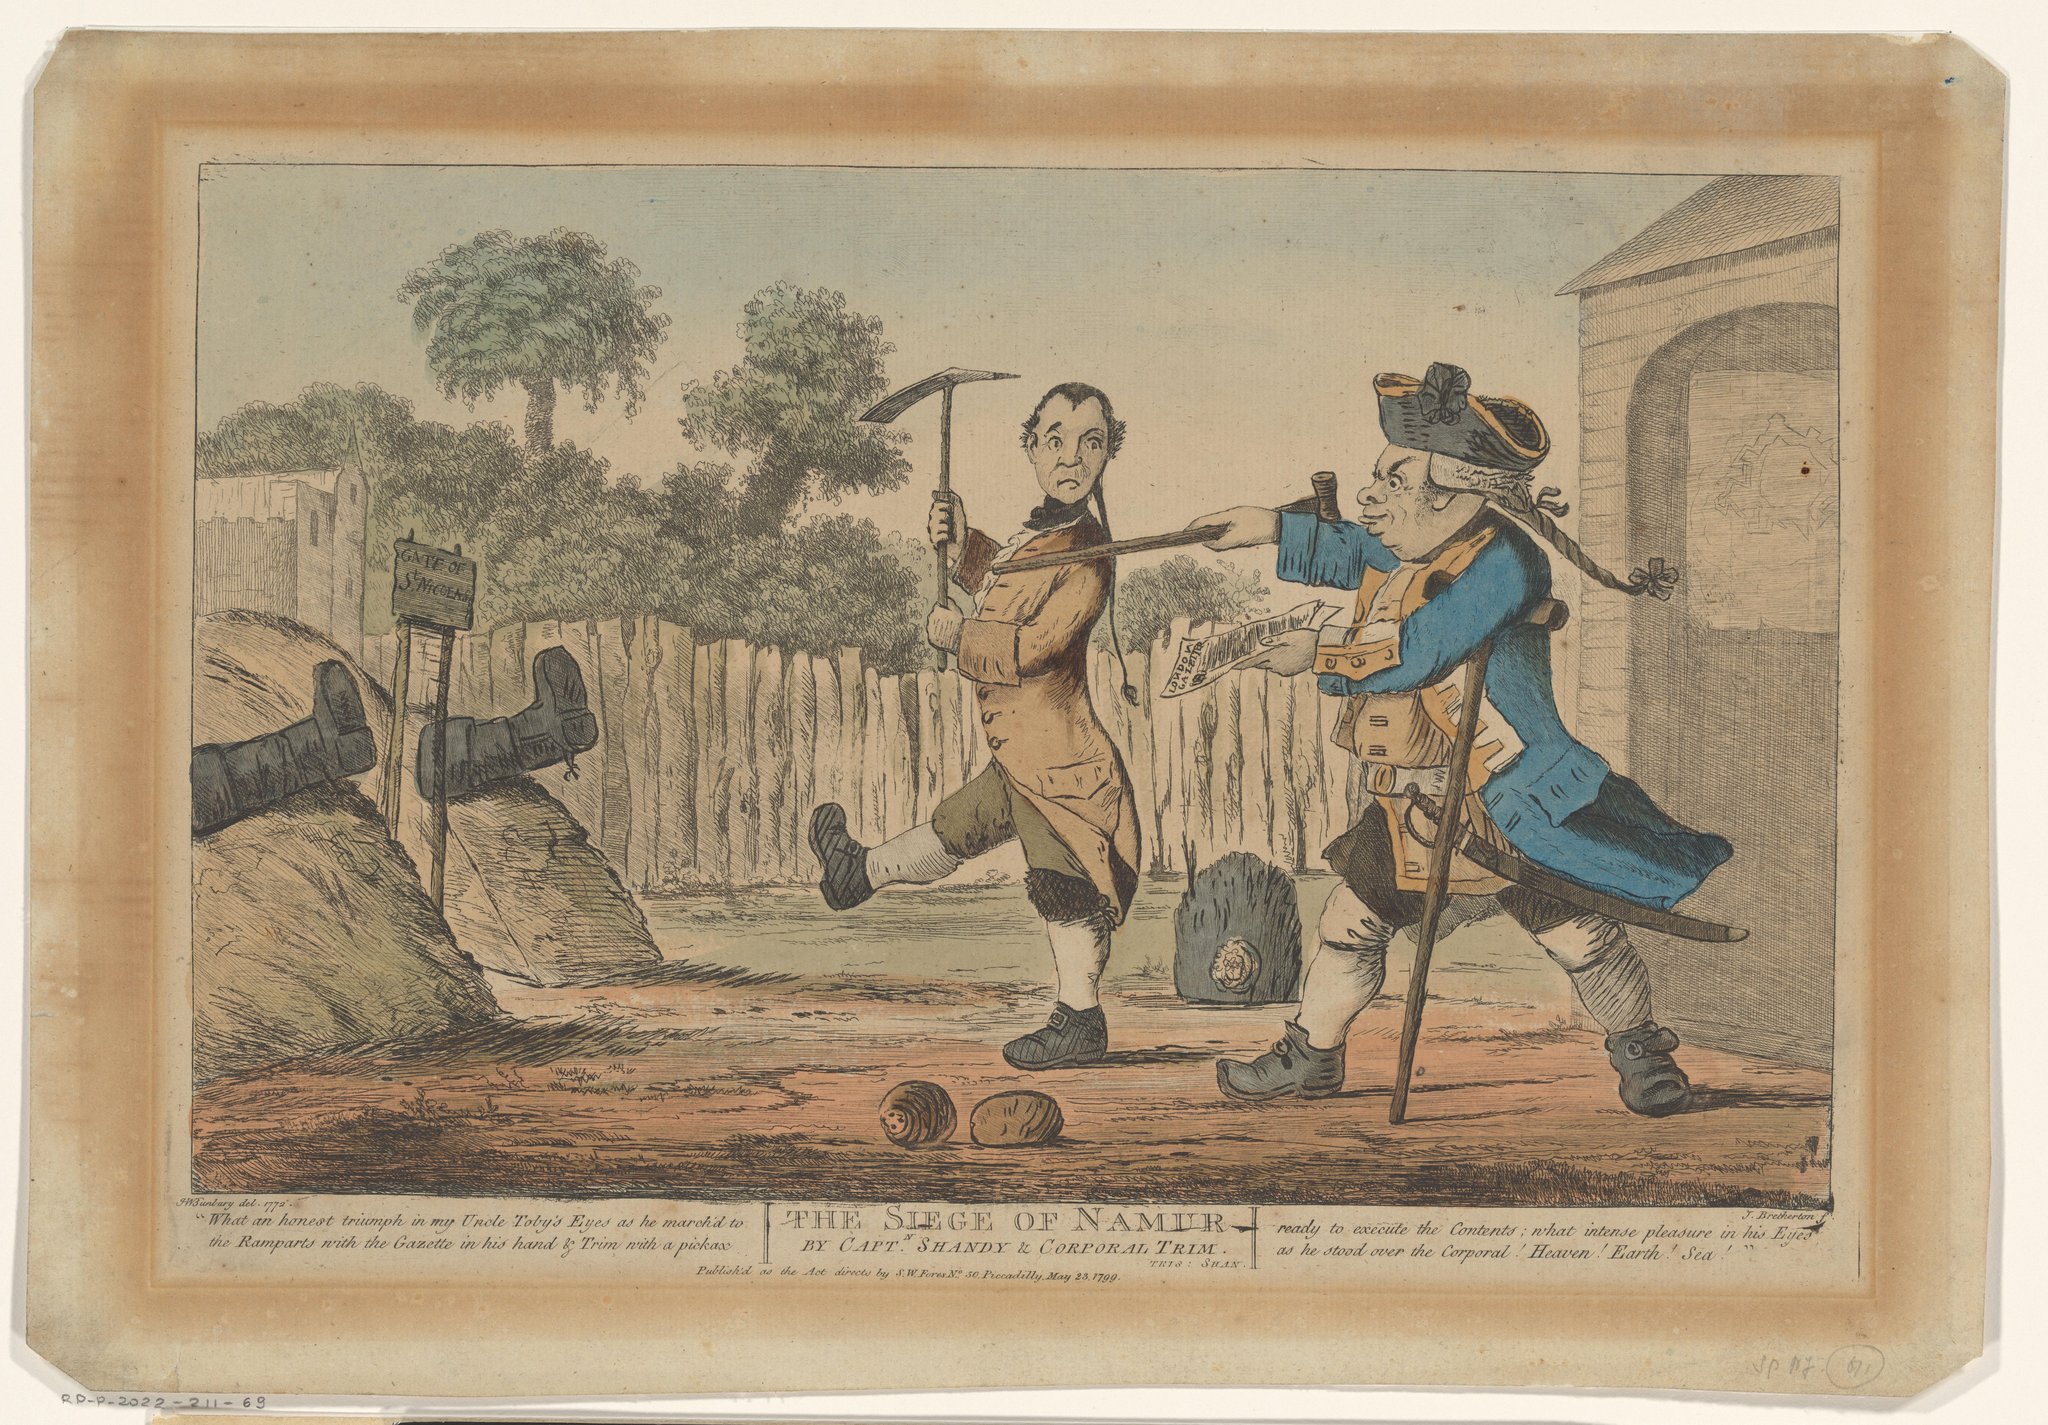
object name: book illustration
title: The Siege of Namur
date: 1759-1767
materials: paper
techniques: etching, hand coloring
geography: london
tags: caricatures (human types), (scenes from) specific works of literature (with author, title), military training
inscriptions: collector's mark: Lugt 2228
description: Oom Toby (rechts) marcheert van rechts naar links, een kruk onder zijn linkerarm, en wijst met zijn rechterkruk in de richting van de vestingwerken (links), waar de 'Gate of St Nicolas' aan elke kant wordt geflankeerd door een laars. In zijn linkerhand houdt hij de 'London Gazette'. Trim, die een houweel omhoog houdt, marcheert voor zijn meester uit. Een illustratie voor Laurence Sterne’s The Life and Opinions of Tristram Shandy, Gentleman (York 1759- 1767).